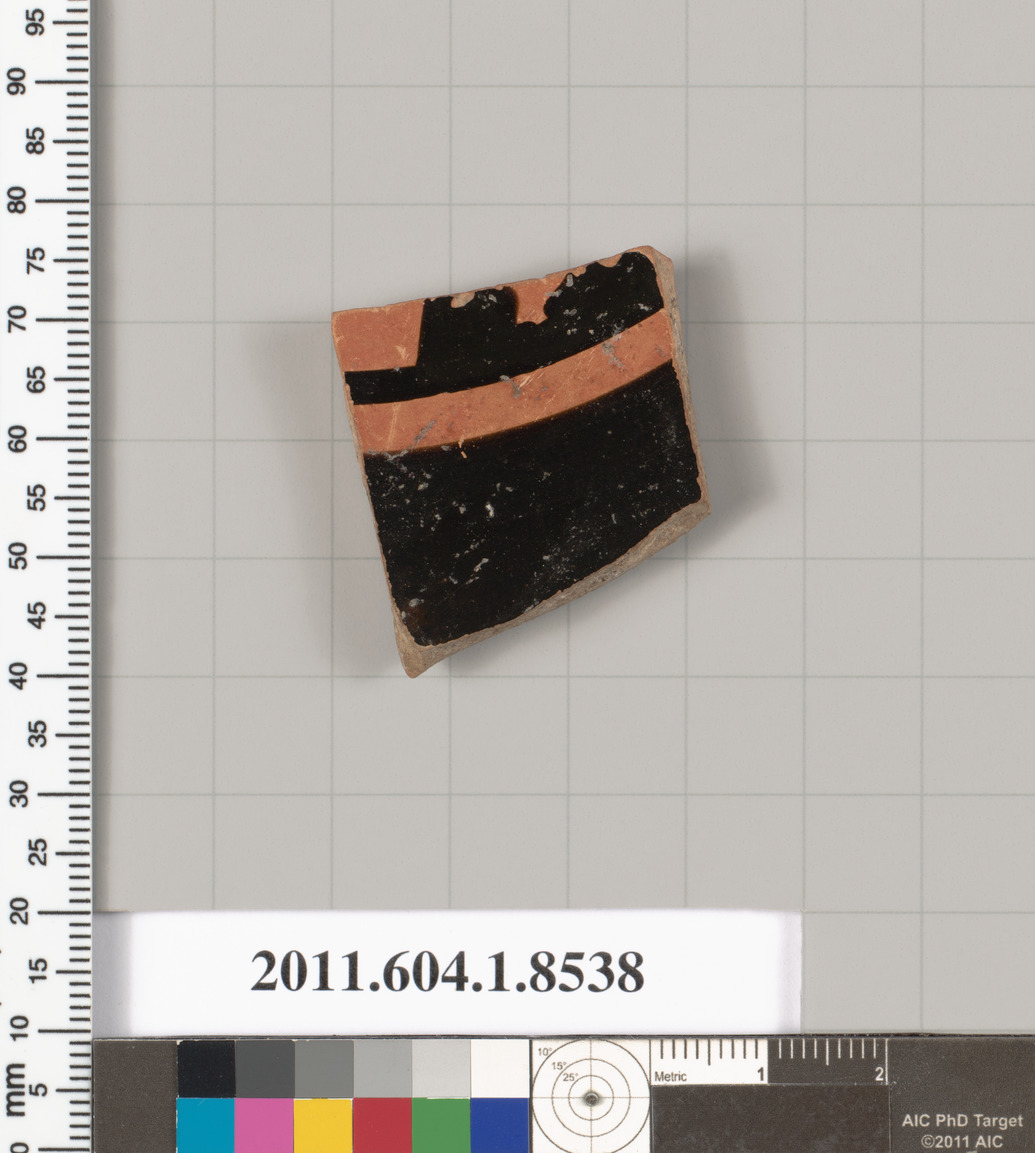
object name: kylix fragment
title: Terracotta fragment of a stemless kylix (drinking cup)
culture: greek, attic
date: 460-450 BCE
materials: terracotta